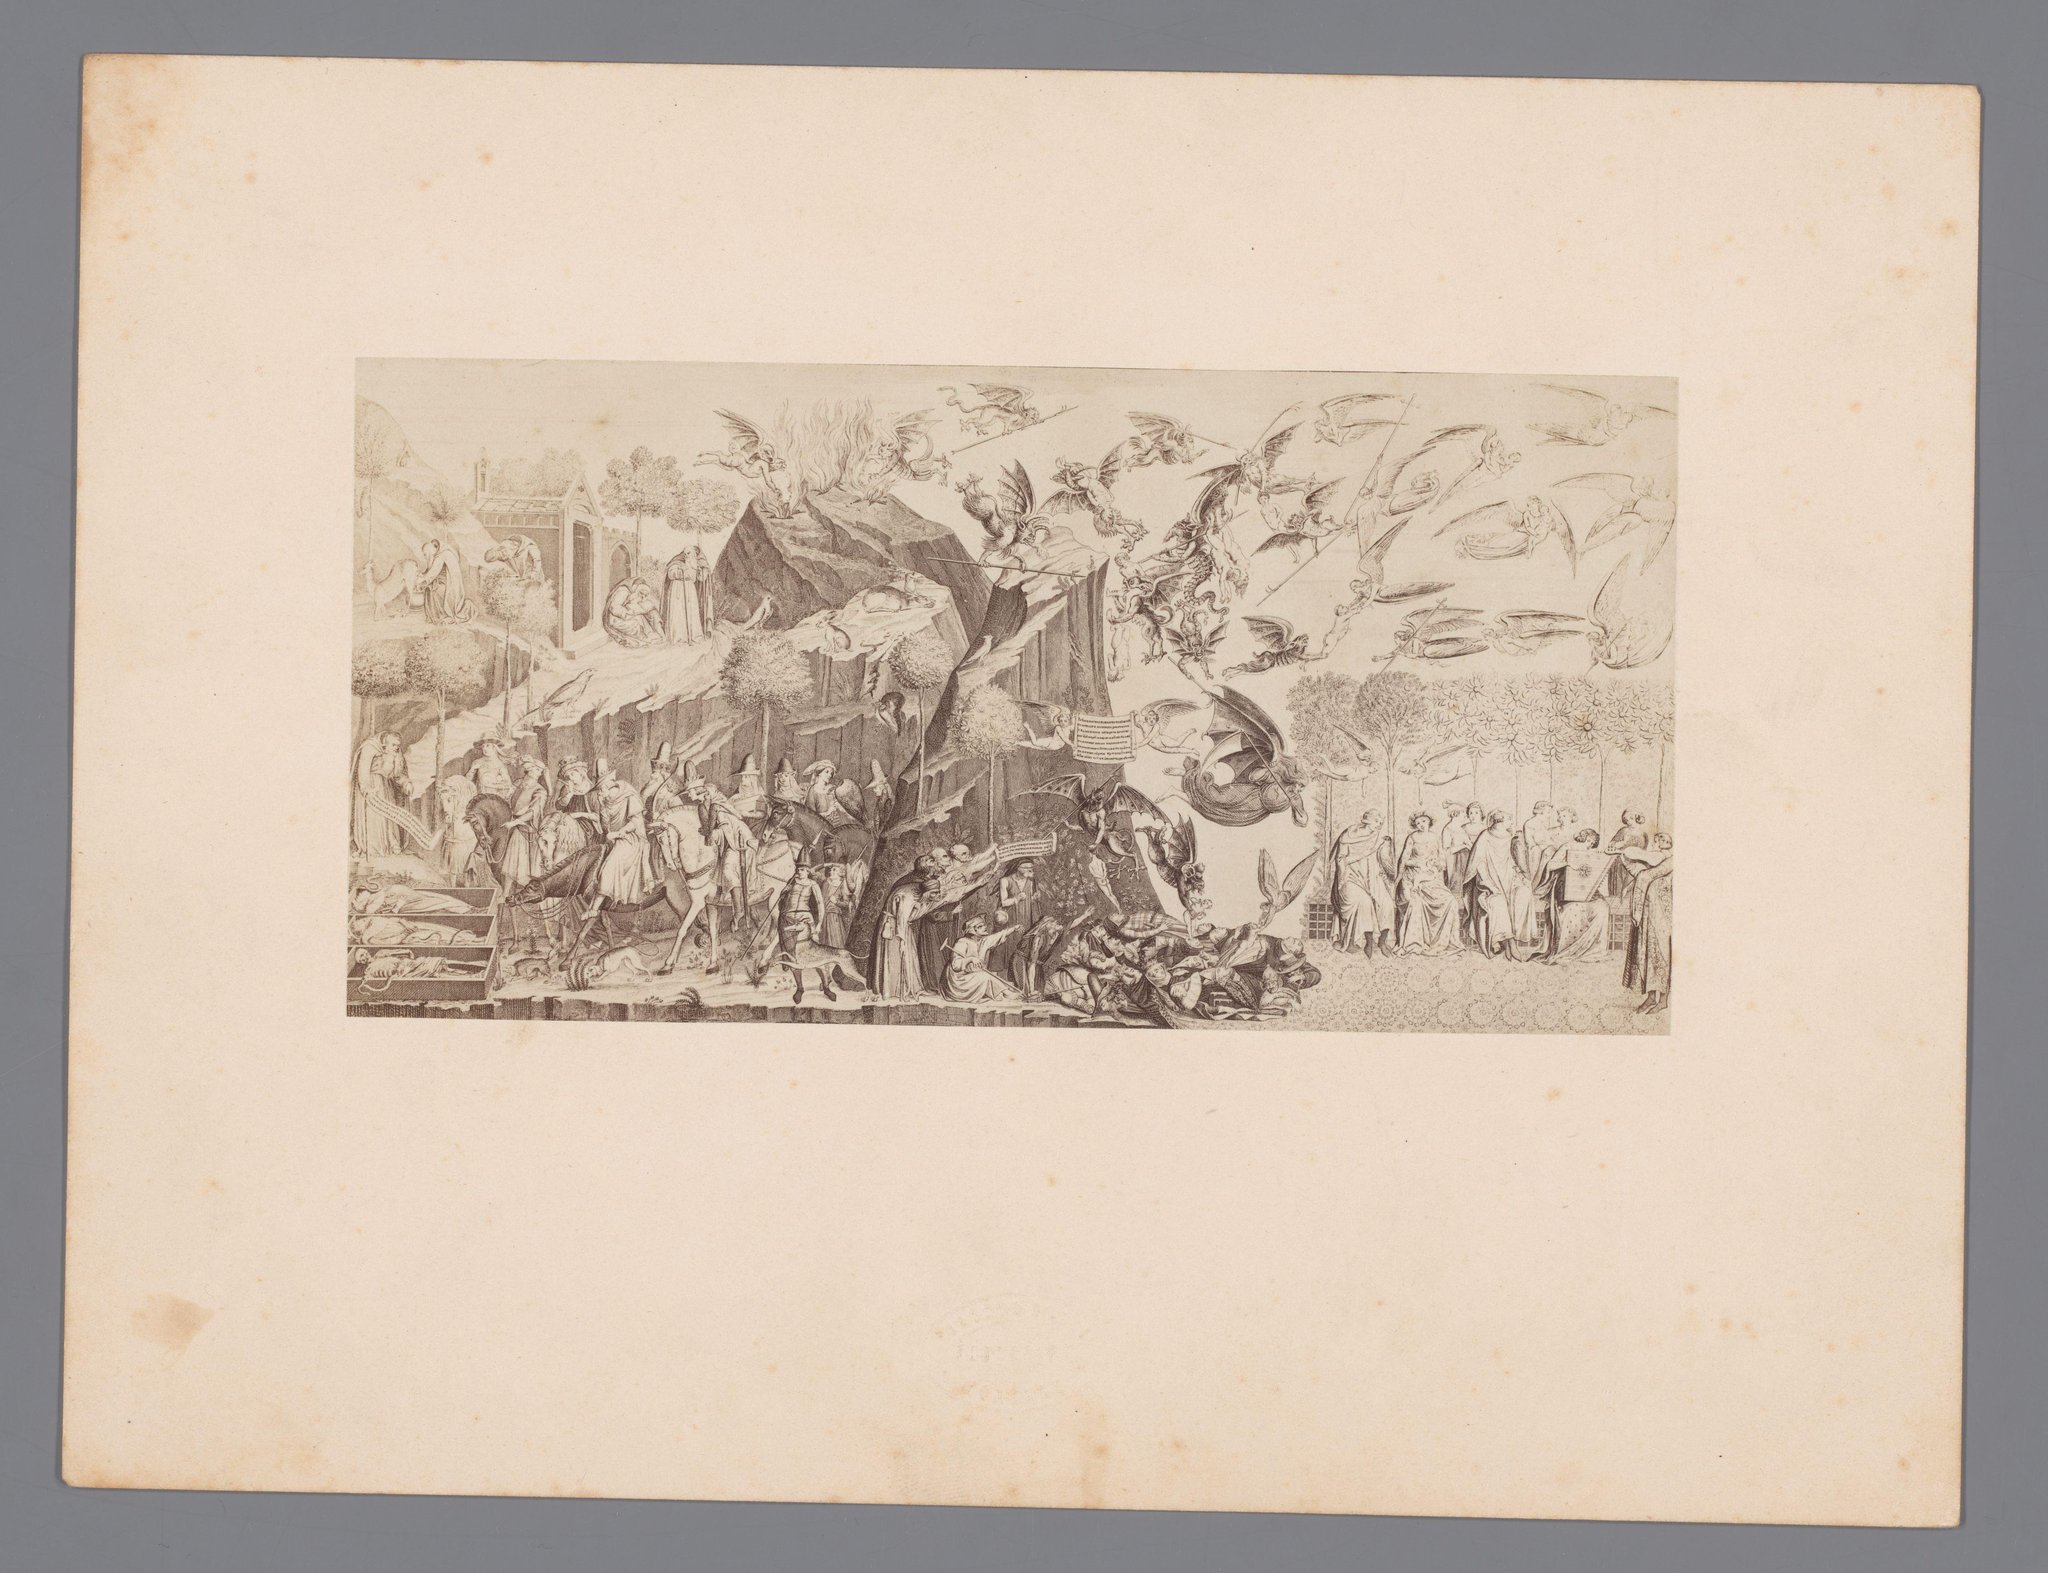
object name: photograph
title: Andrea Orgagna - Il Trionfo della Morte. Campo Santo, Pisa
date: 1864-1881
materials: cardboard, paper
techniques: albumen print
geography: pisa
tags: wall-covering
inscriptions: number: ‘647’